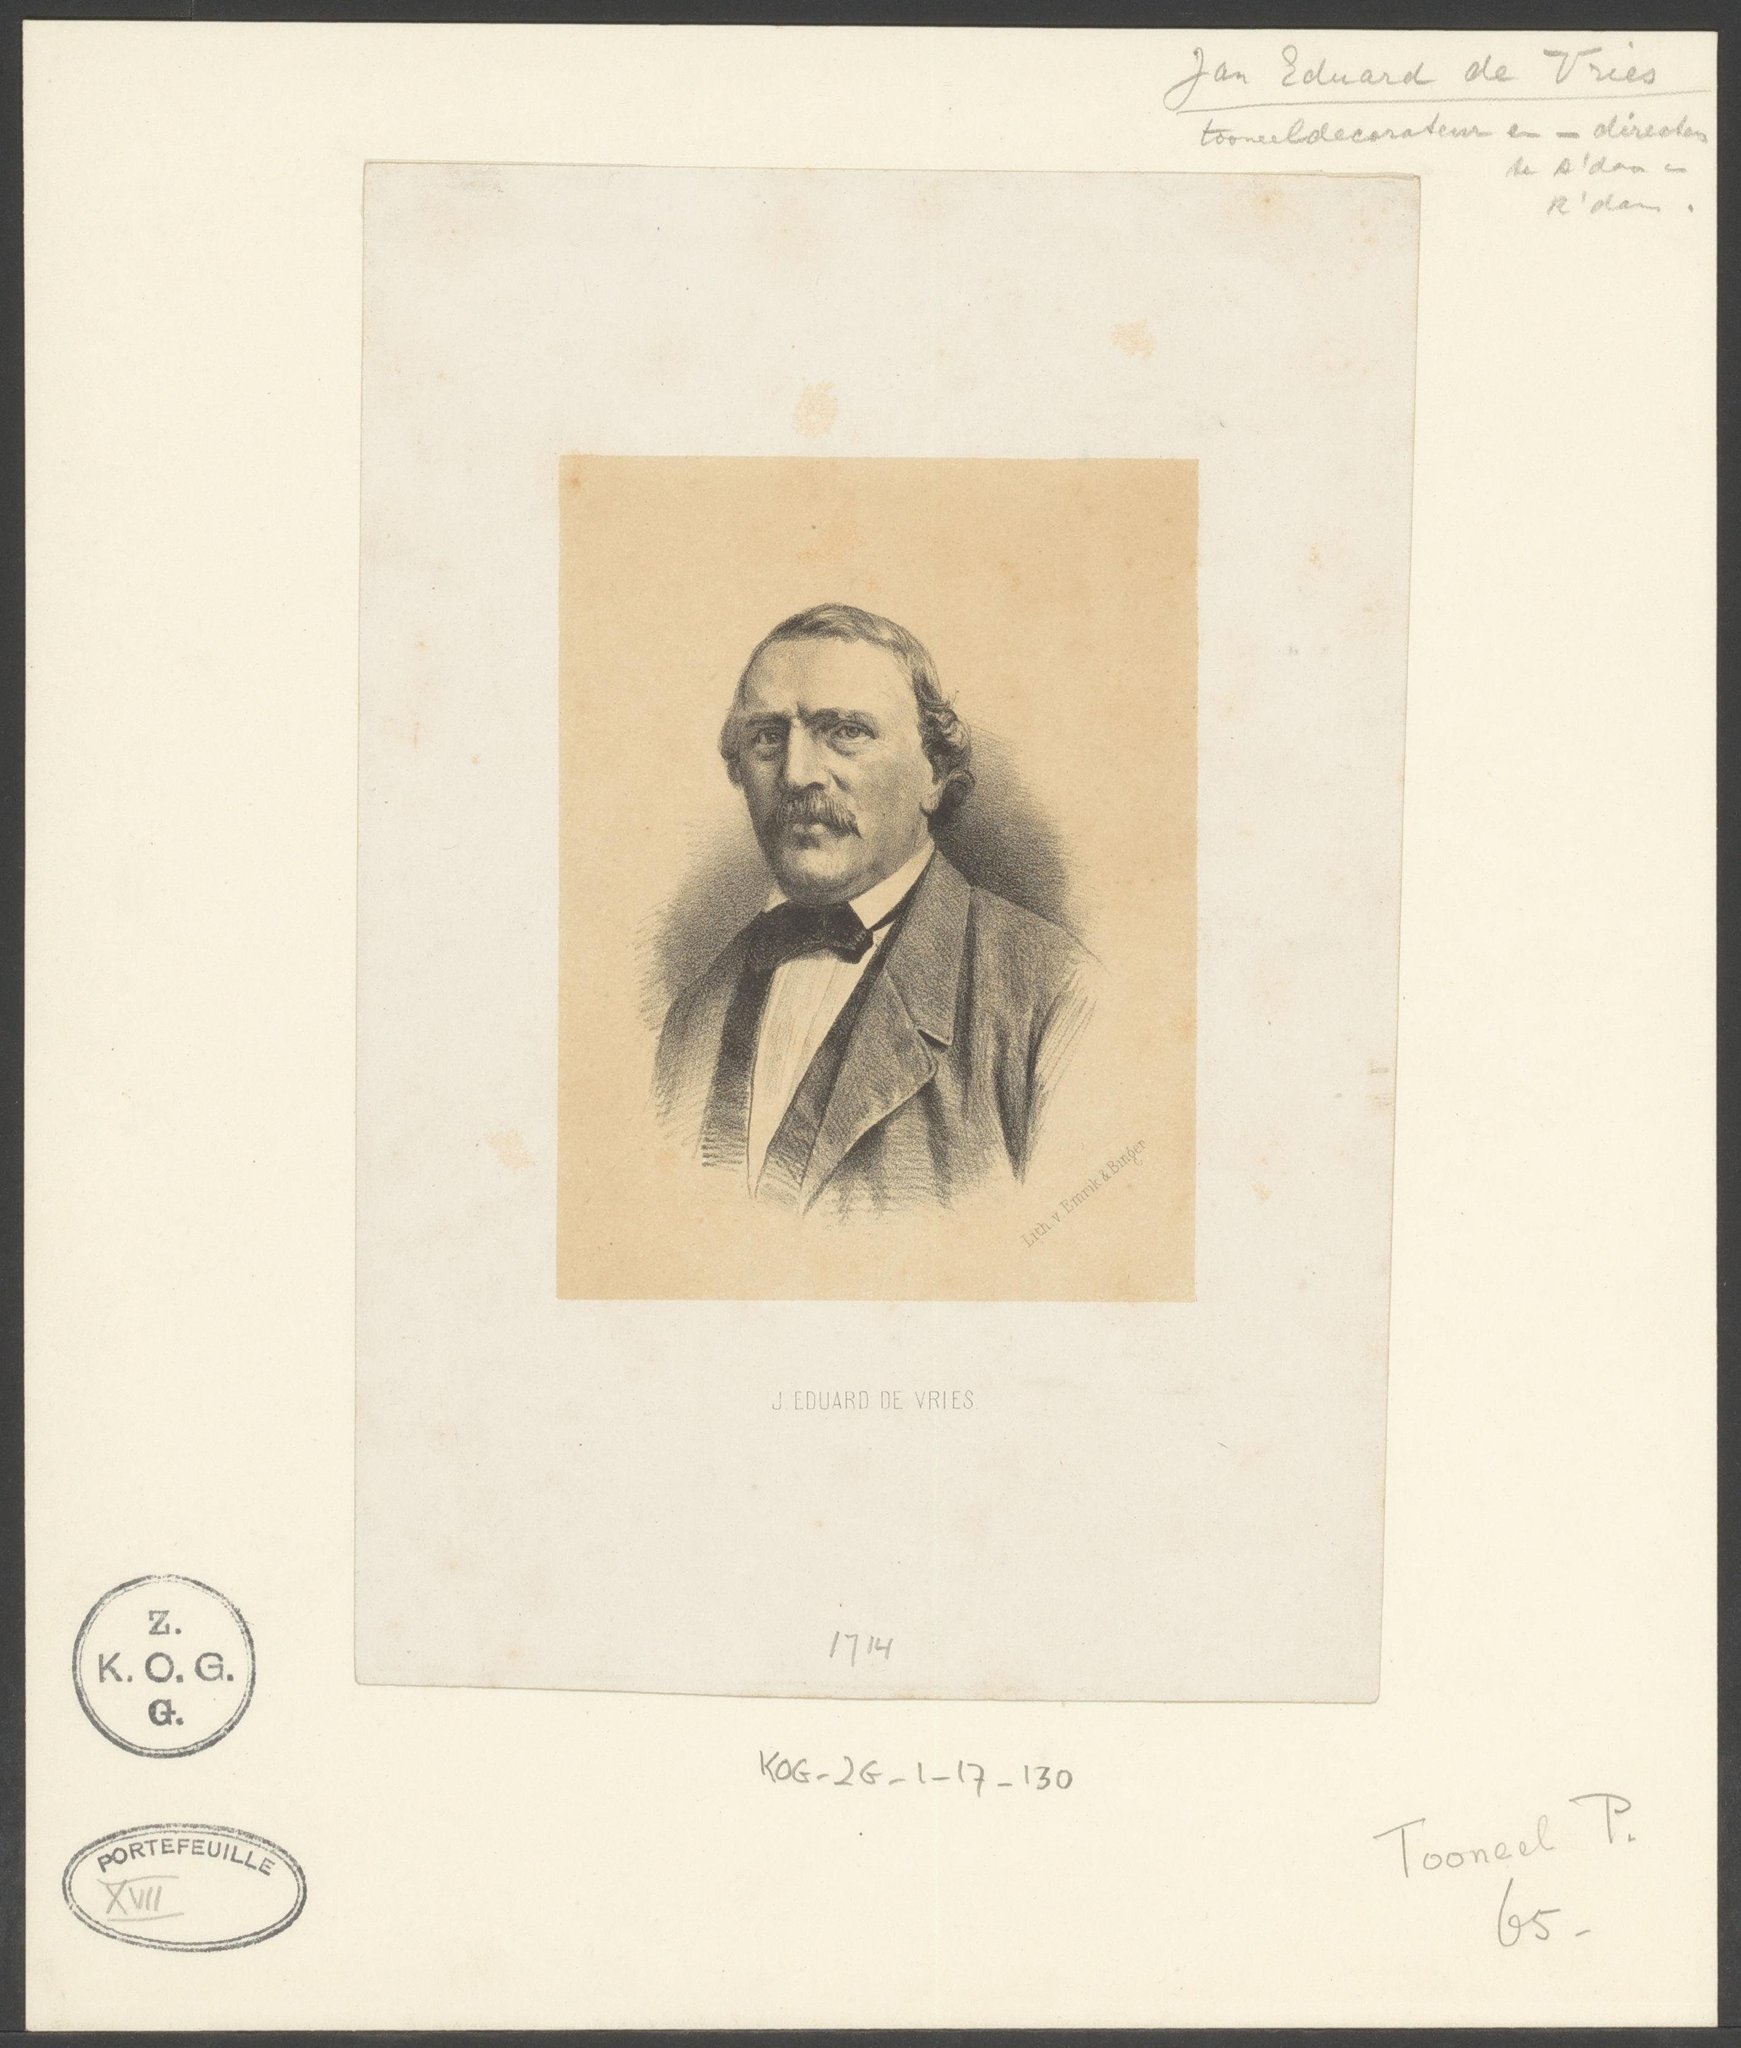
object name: print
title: J. Eduard de Vries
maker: Anonymous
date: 1857-1875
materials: paper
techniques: tone lithography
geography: paris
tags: amsterdam, painter, jan eduard de vries, historical persons, portrait of actor, actress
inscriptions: stamp, collector's mark: Lugt 1641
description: Onderwerpsrubrieken binnen de Atlas Zeden en Gewoonten: Tooneel, Portretten van toneelspelers.